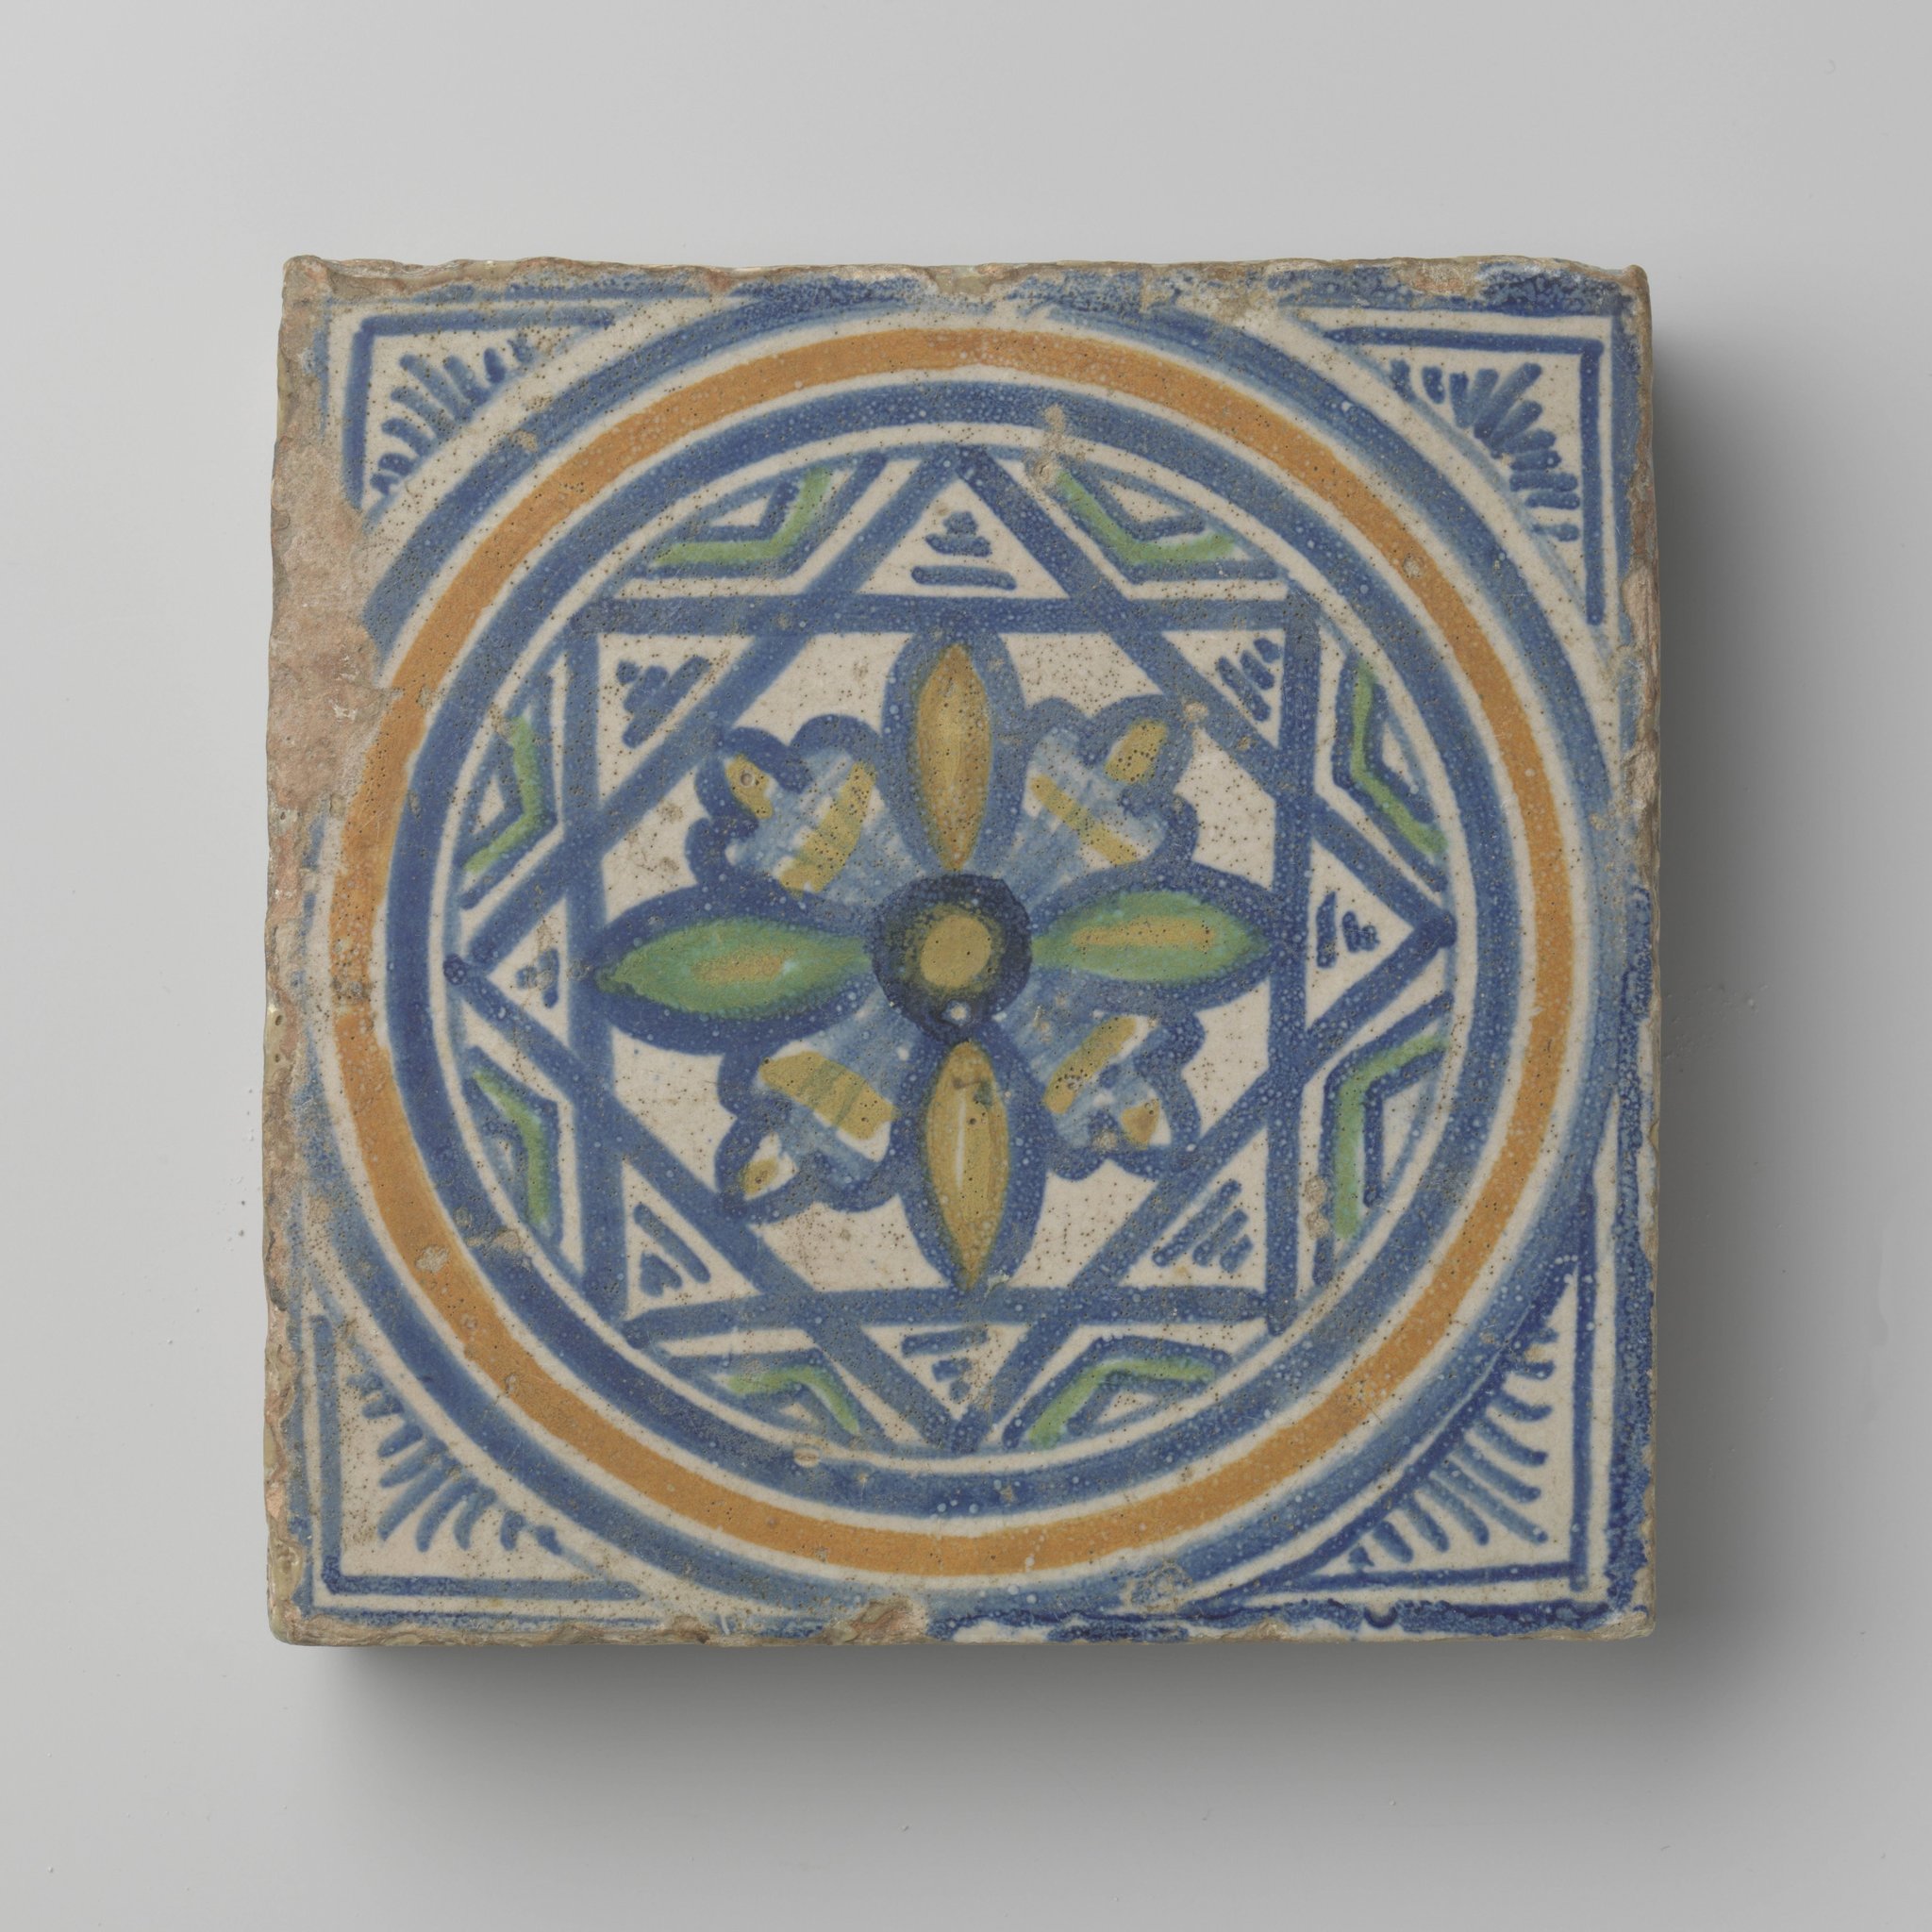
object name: architectural element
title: Vloertegel met veelkleurige rozet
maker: Anonymous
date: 1545-1570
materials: earthenware, glaze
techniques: maiolica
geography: antwerp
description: Vierkante vloertegel met een veelkleurige (blauw, groen, geel en oranje) rozet binnen twee elkaar snijdende ruiten. In de hoeken, stralen.